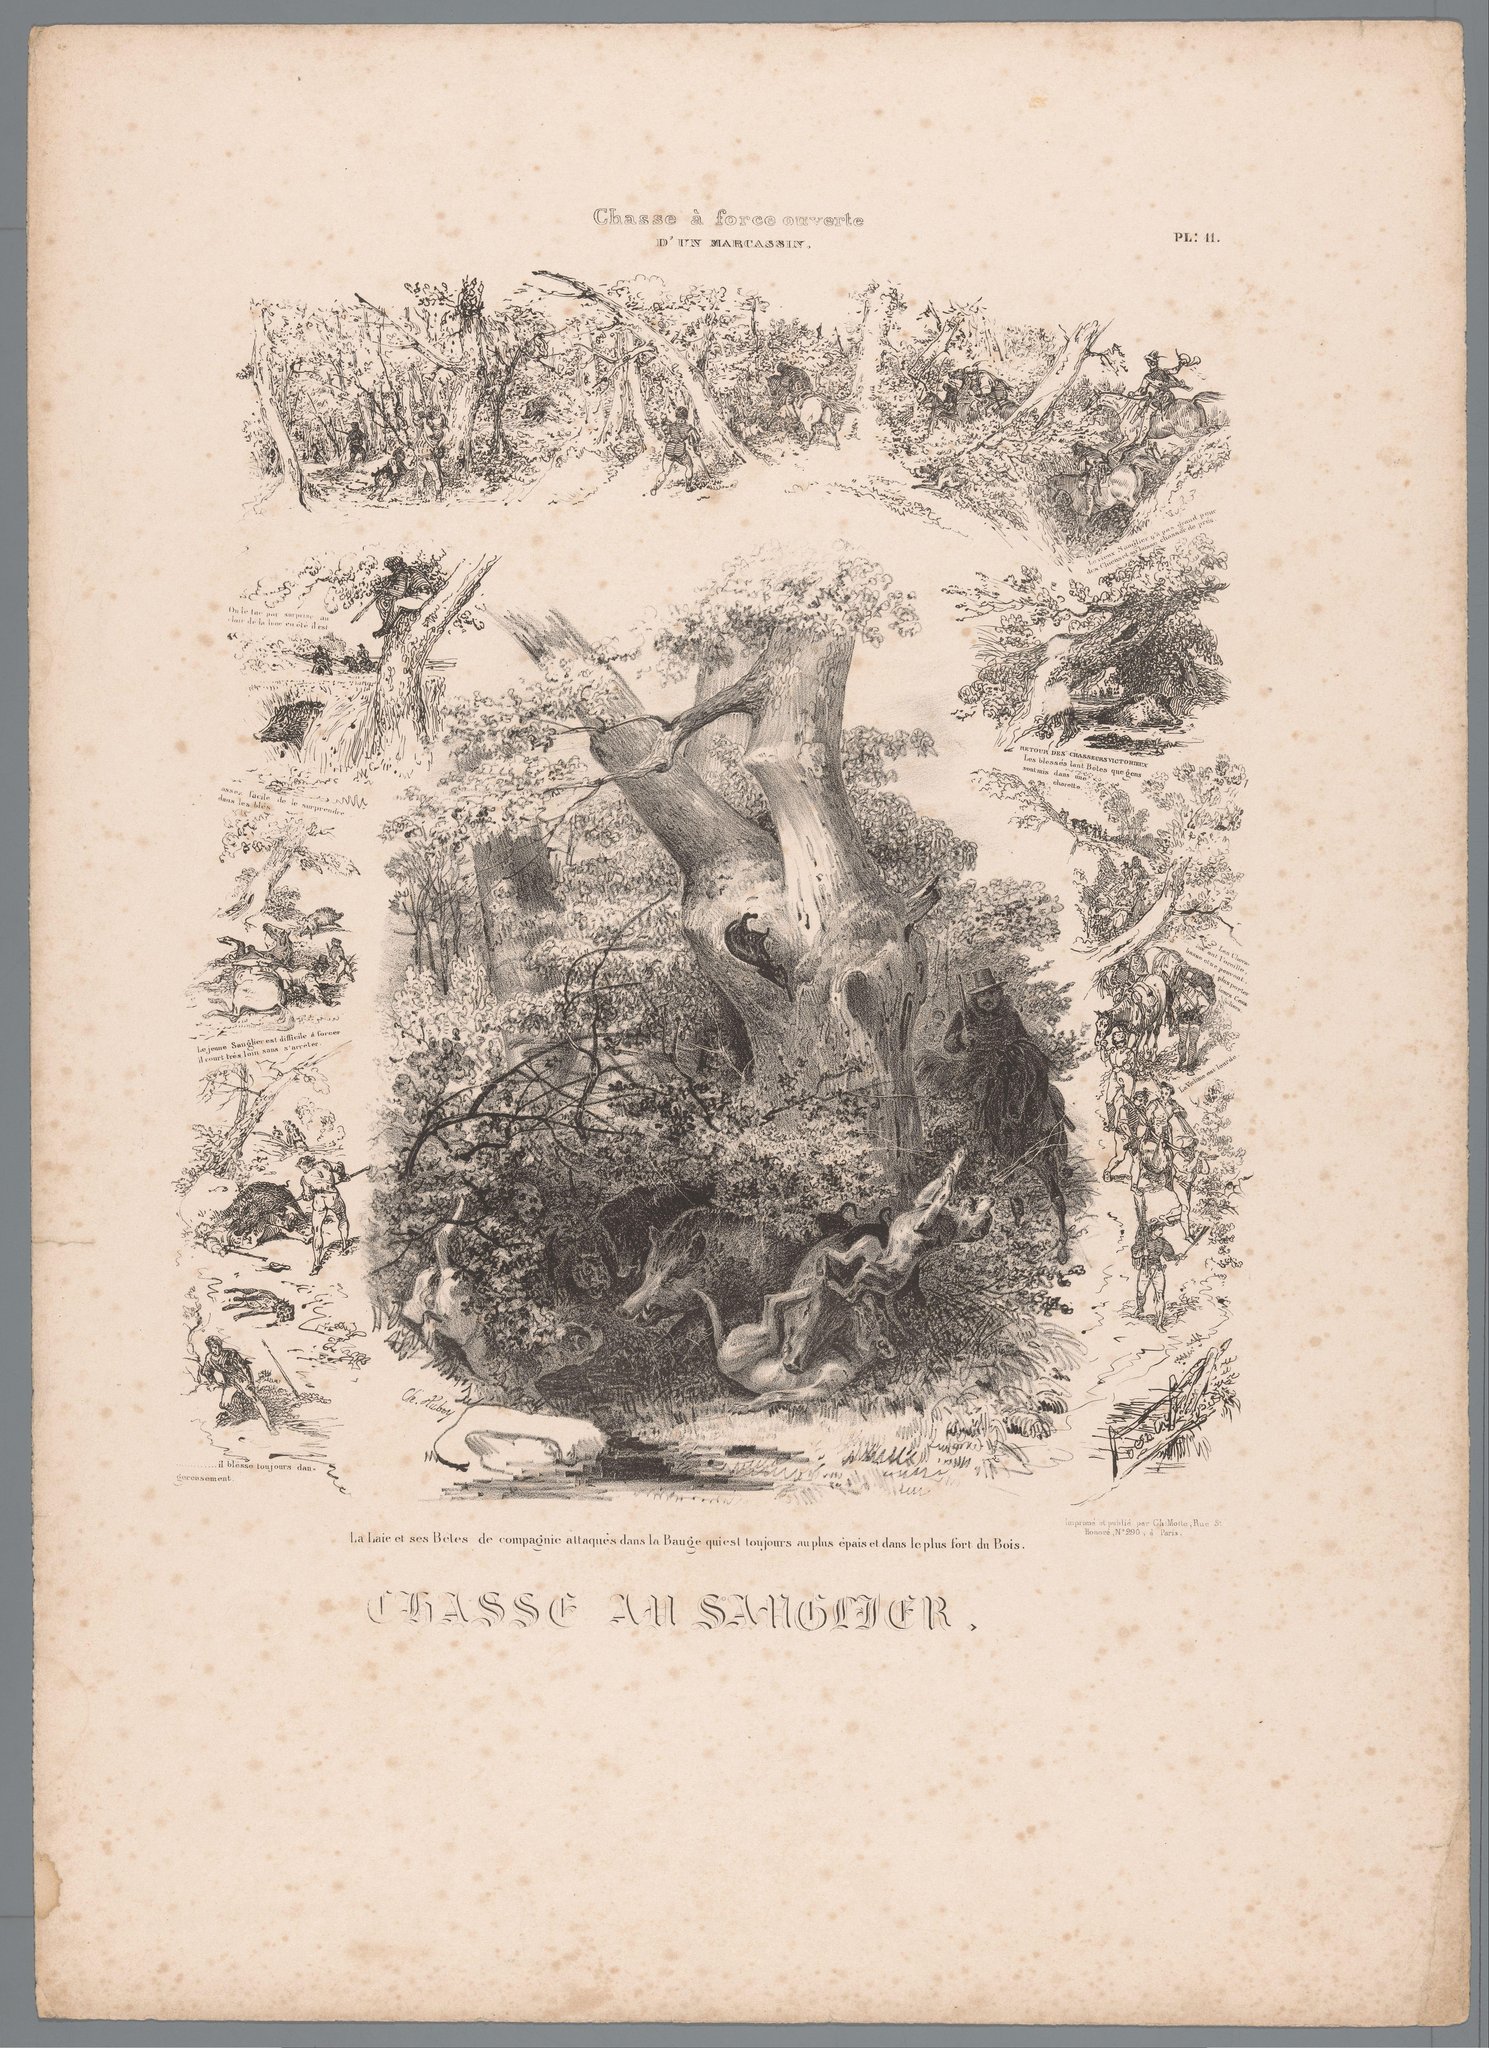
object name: print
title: Chasse au Sanglier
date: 1836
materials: paper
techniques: lithography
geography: paris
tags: hunting dogs, boar-hunting, hoofed animals: boar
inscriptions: check stamp: Lugt 1828c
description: Deze prent maakt deel uit van een omslag met twaalf prenten. Rondom de hoofdvoorstelling worden diverse jachttechnieken uitgelegd in woord en beeld.